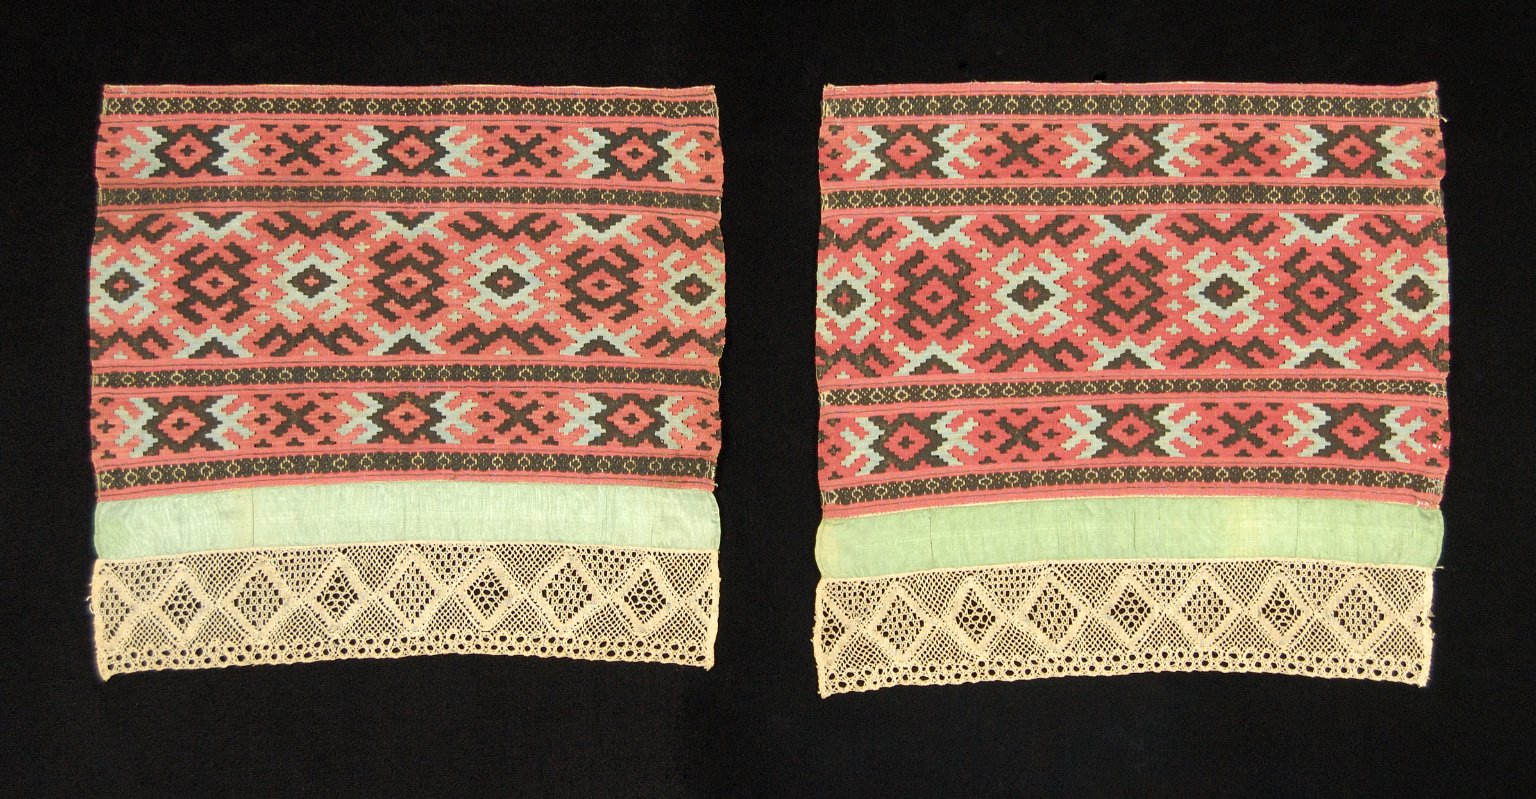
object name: textile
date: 1840-1870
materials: linen, silk